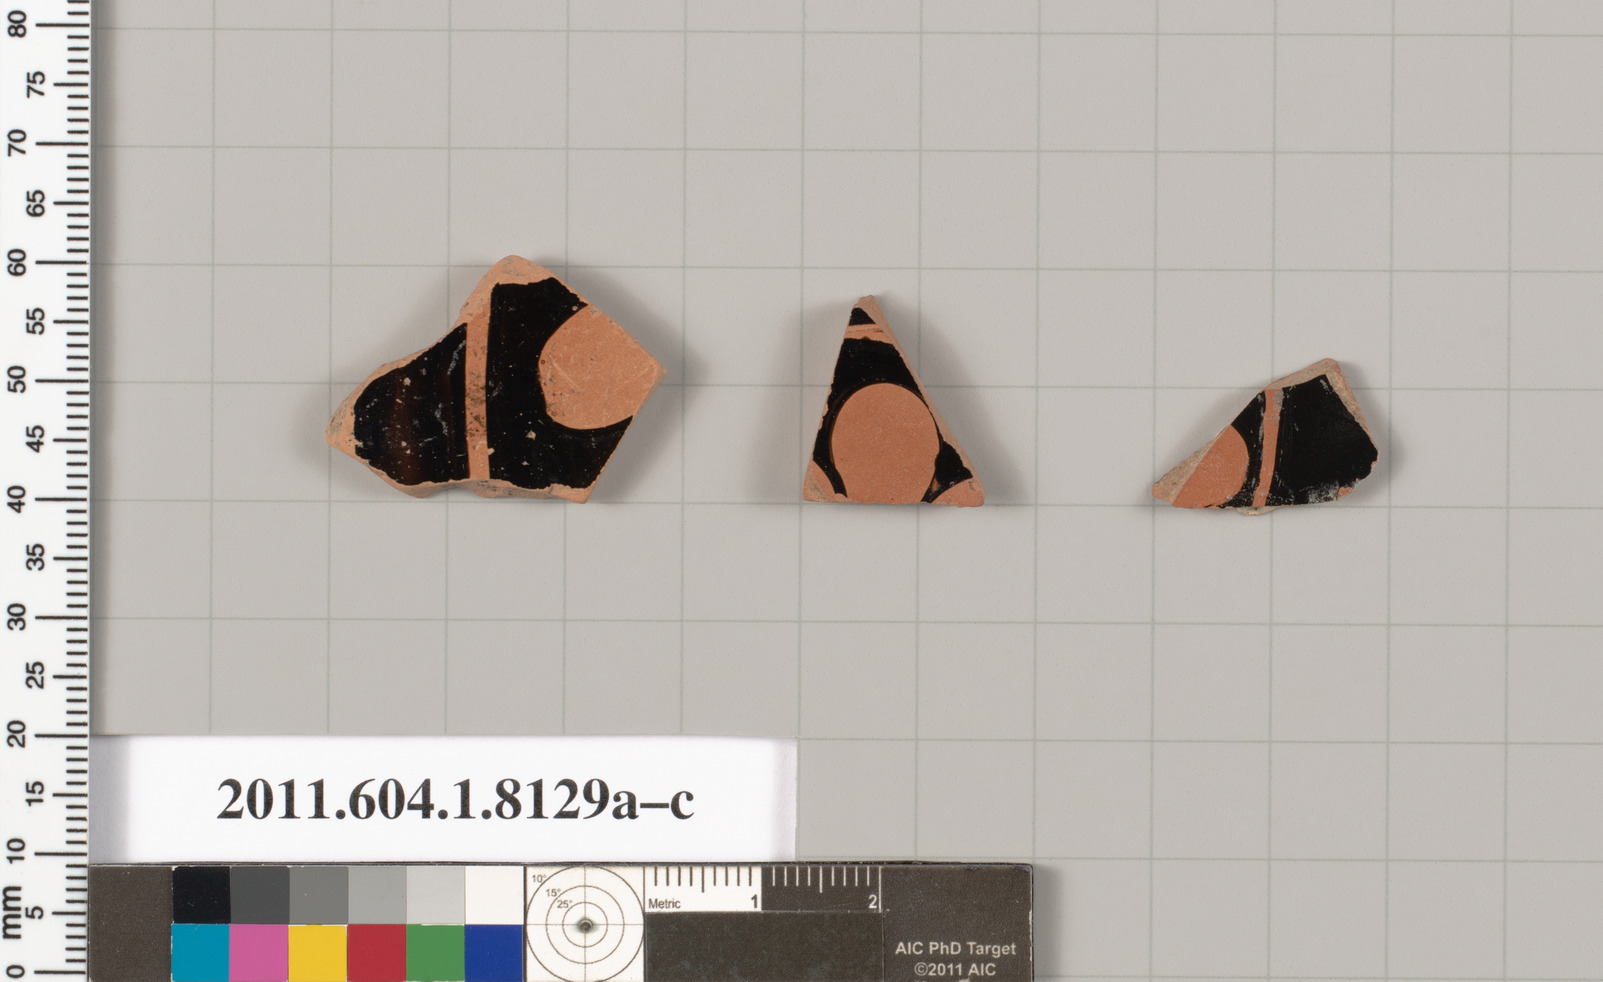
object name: kylix fragment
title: Terracotta fragments of kylikes (drinking cups)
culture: greek, attic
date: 534-468 BCE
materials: terracotta